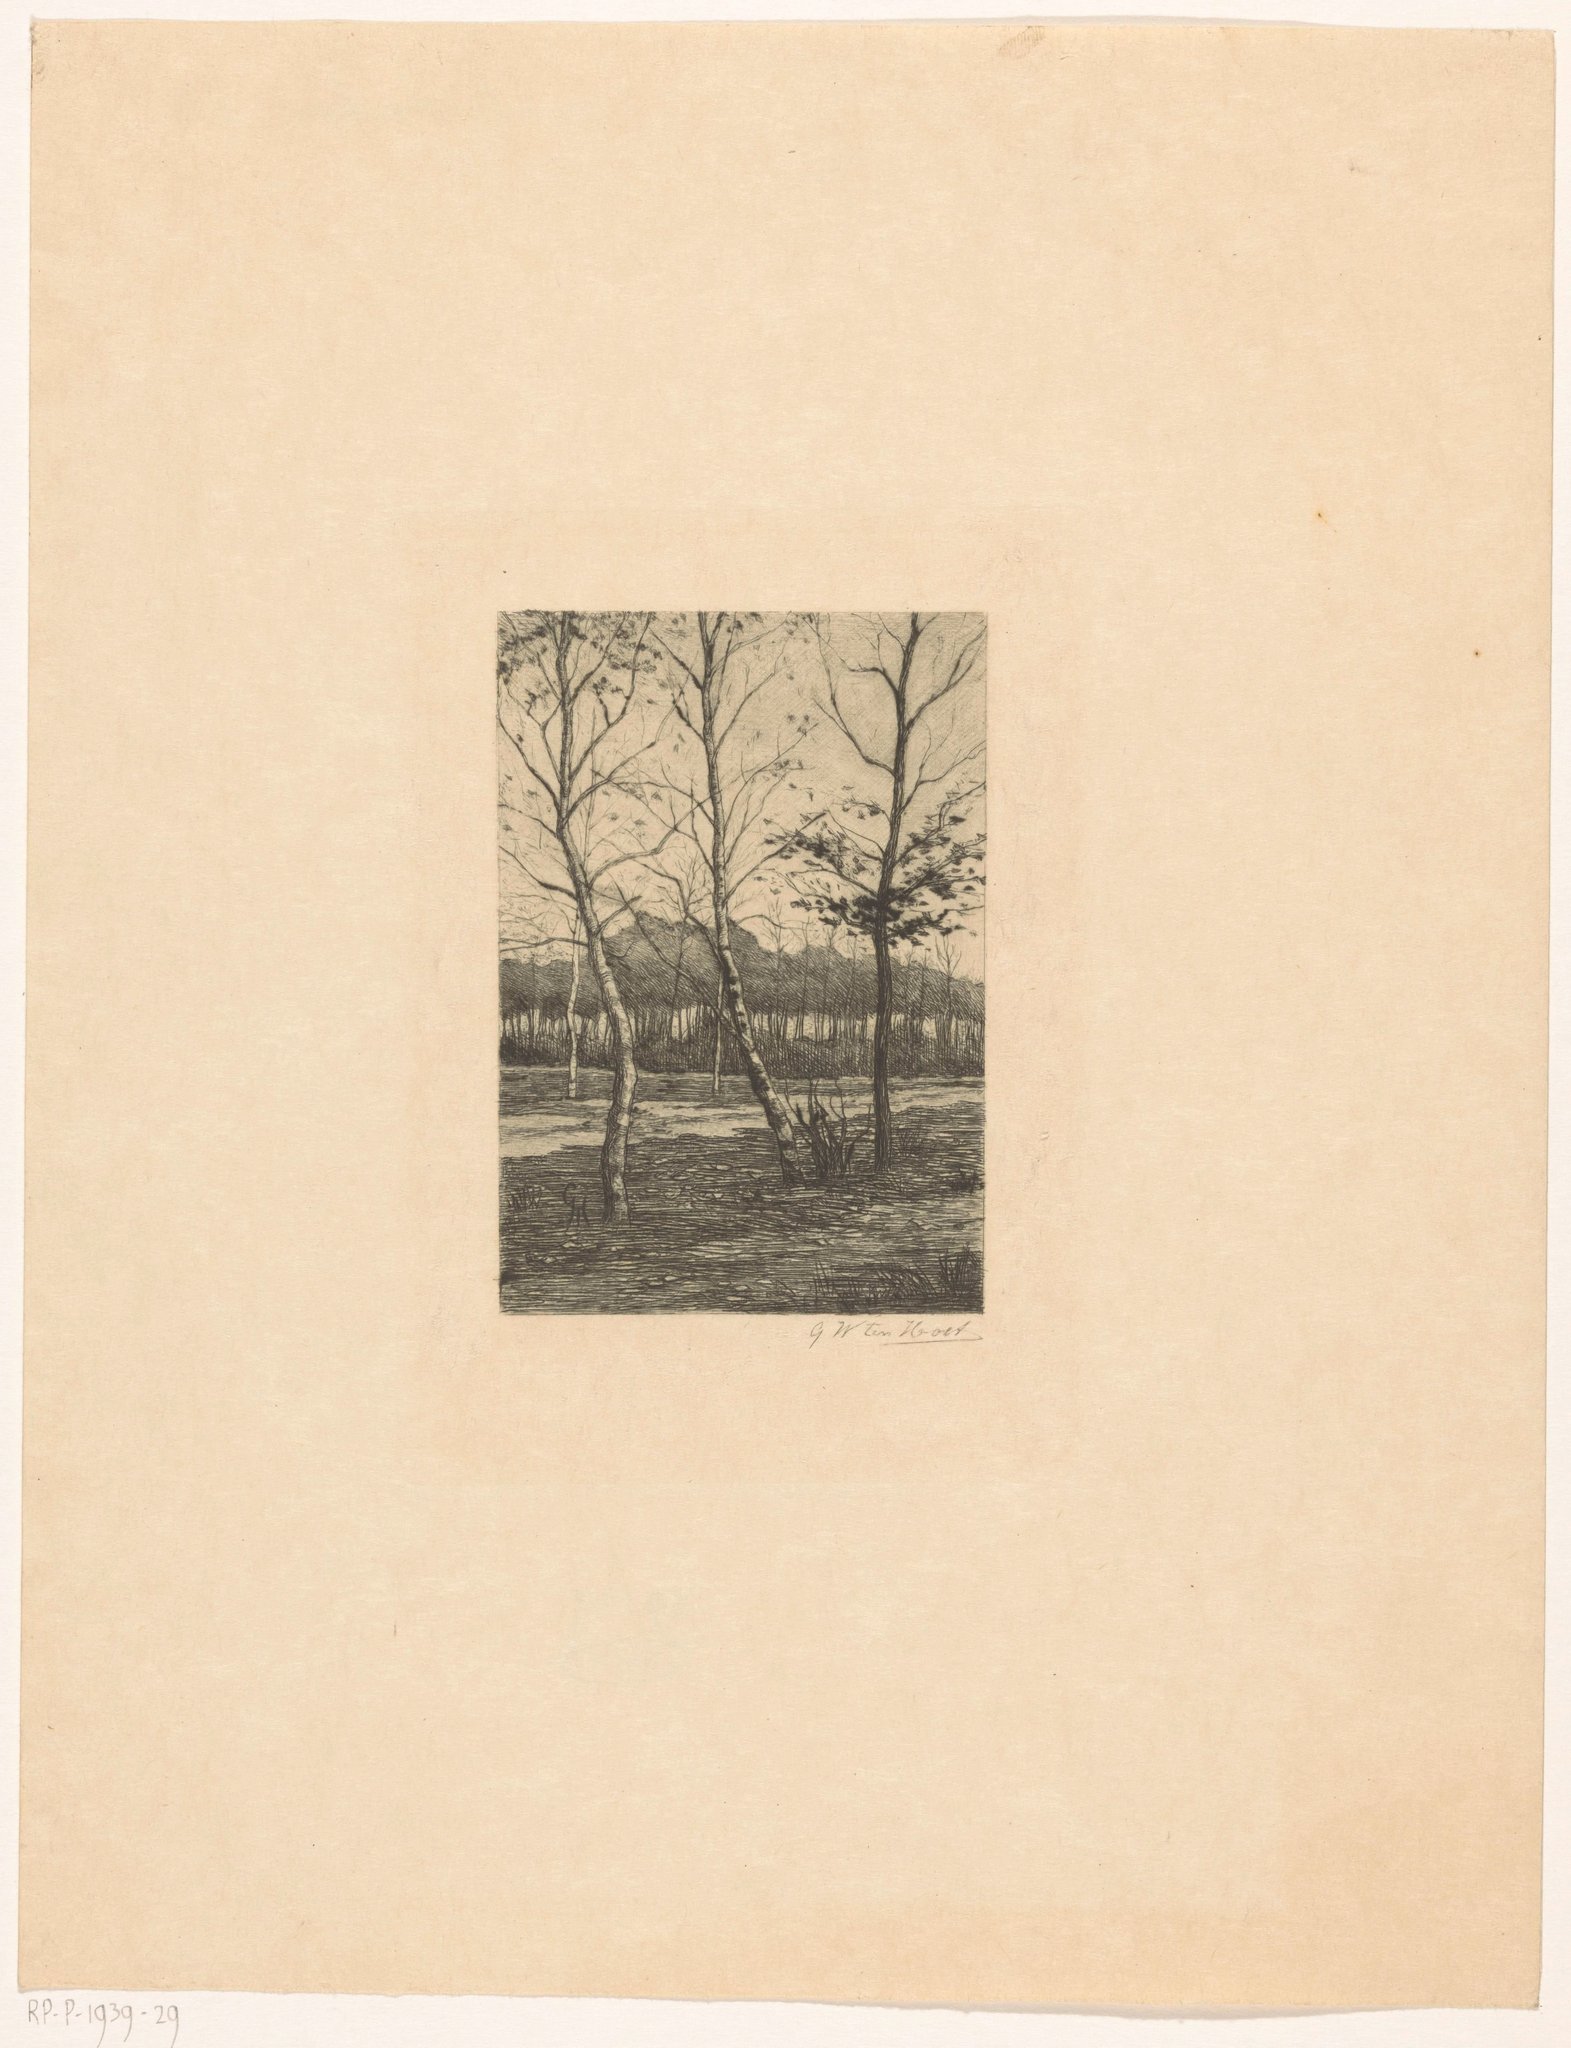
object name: print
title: November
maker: gerarda wilhelmina ten hoet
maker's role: print maker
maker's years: 1857-1939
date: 1867-1939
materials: paper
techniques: etching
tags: fringe, edge of the wood, trees: birch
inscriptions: collector's mark: Lugt 2228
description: Op de voorgrond drie berken. Op de achtergrond een bosrand.